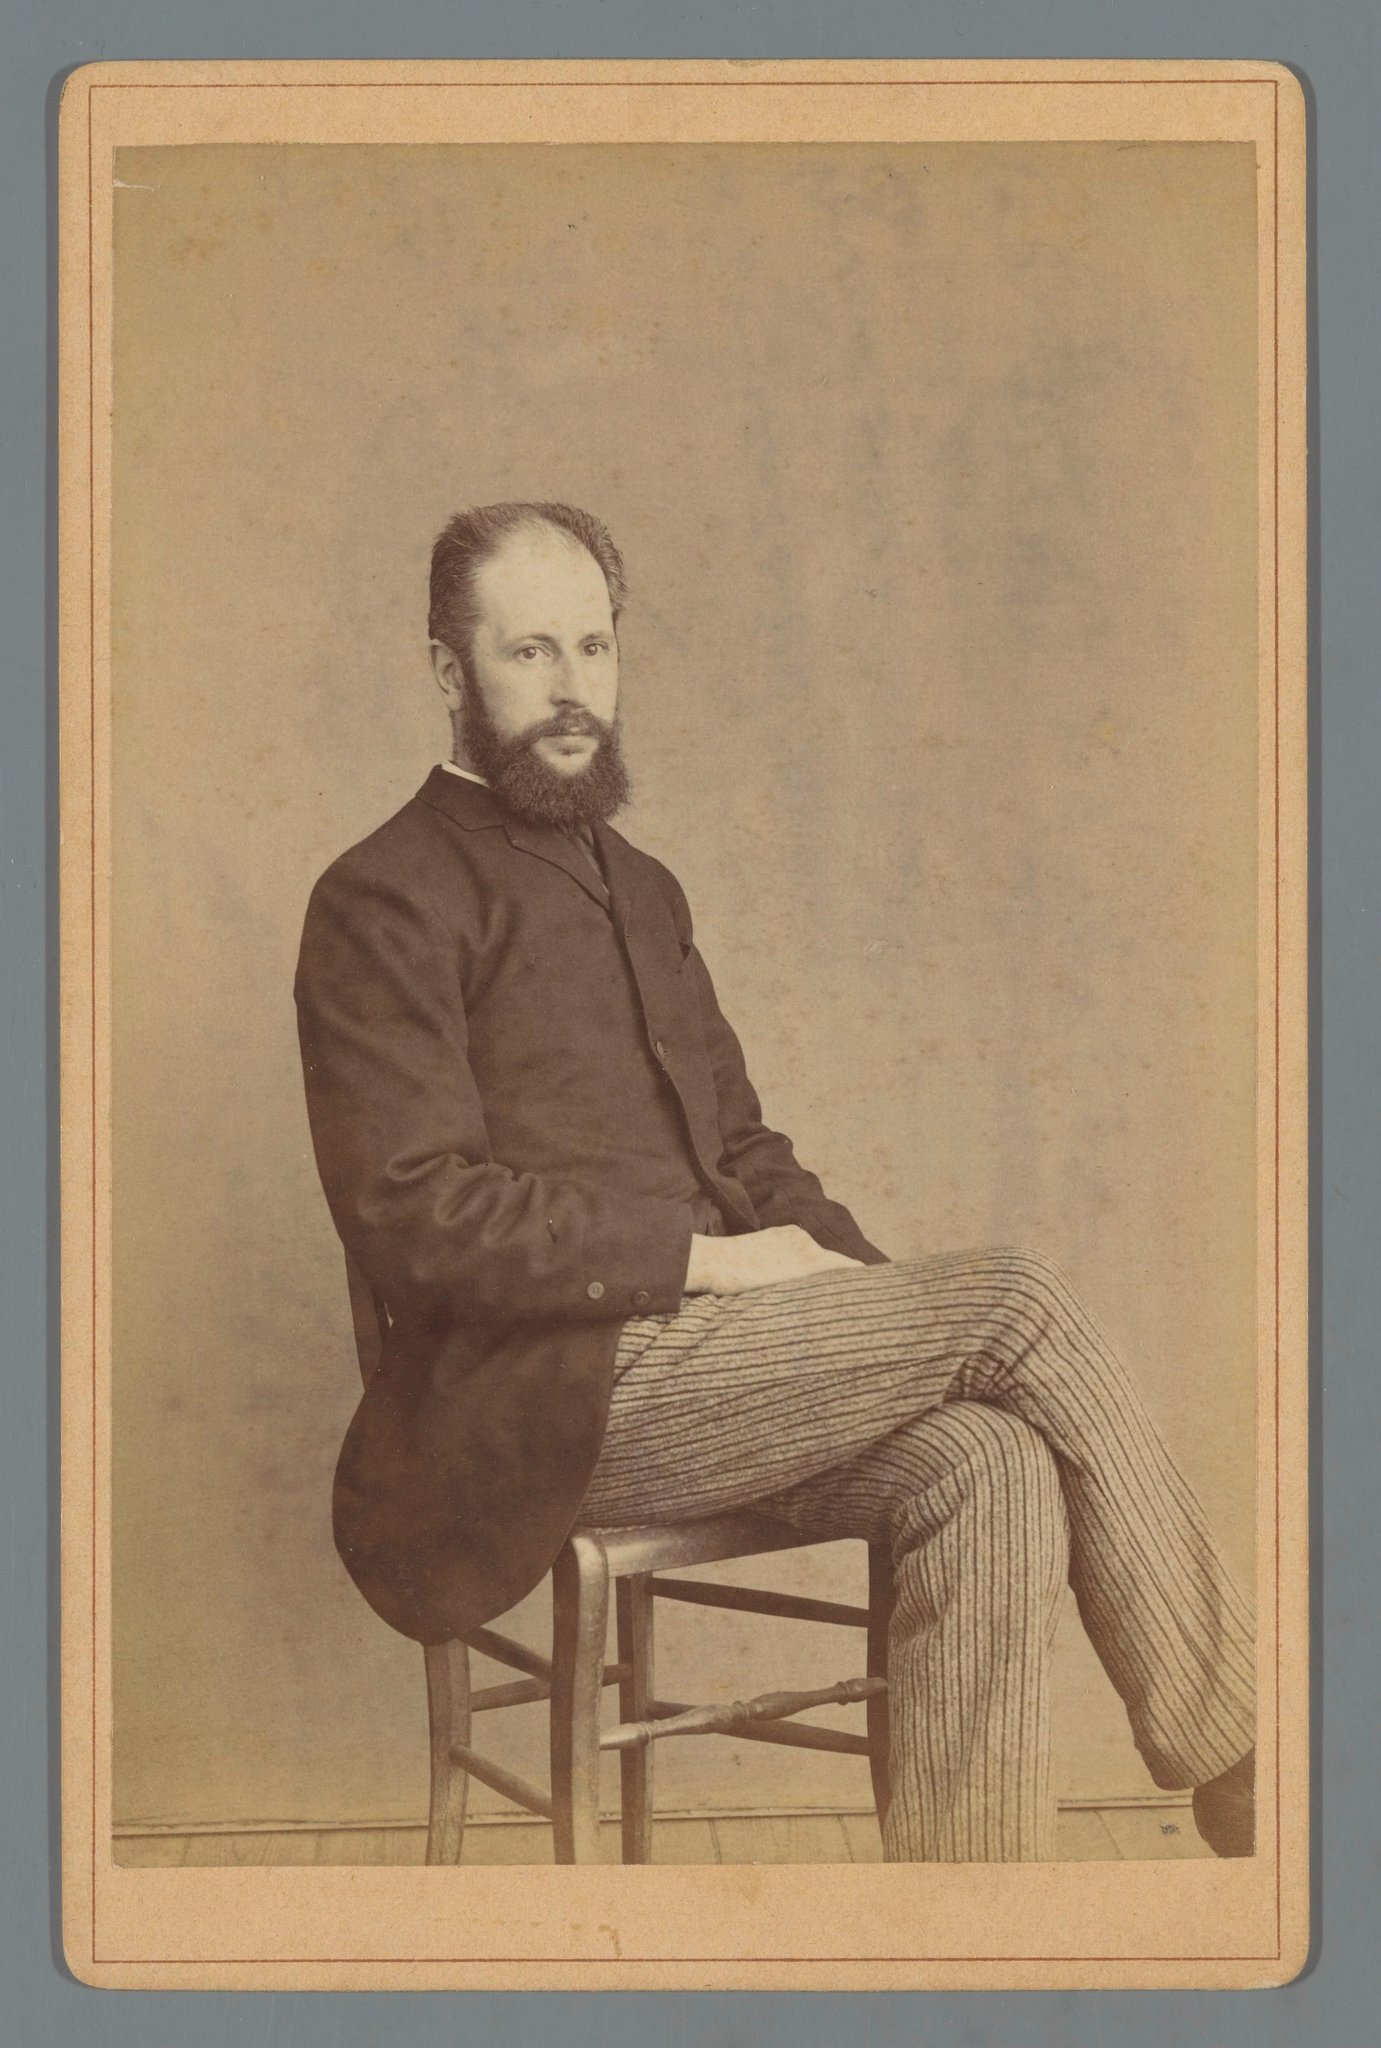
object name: cabinet photograph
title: Portret van een onbekende man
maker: Anonymous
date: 1880-1905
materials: cardboard, photographic support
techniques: albumen print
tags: adult man